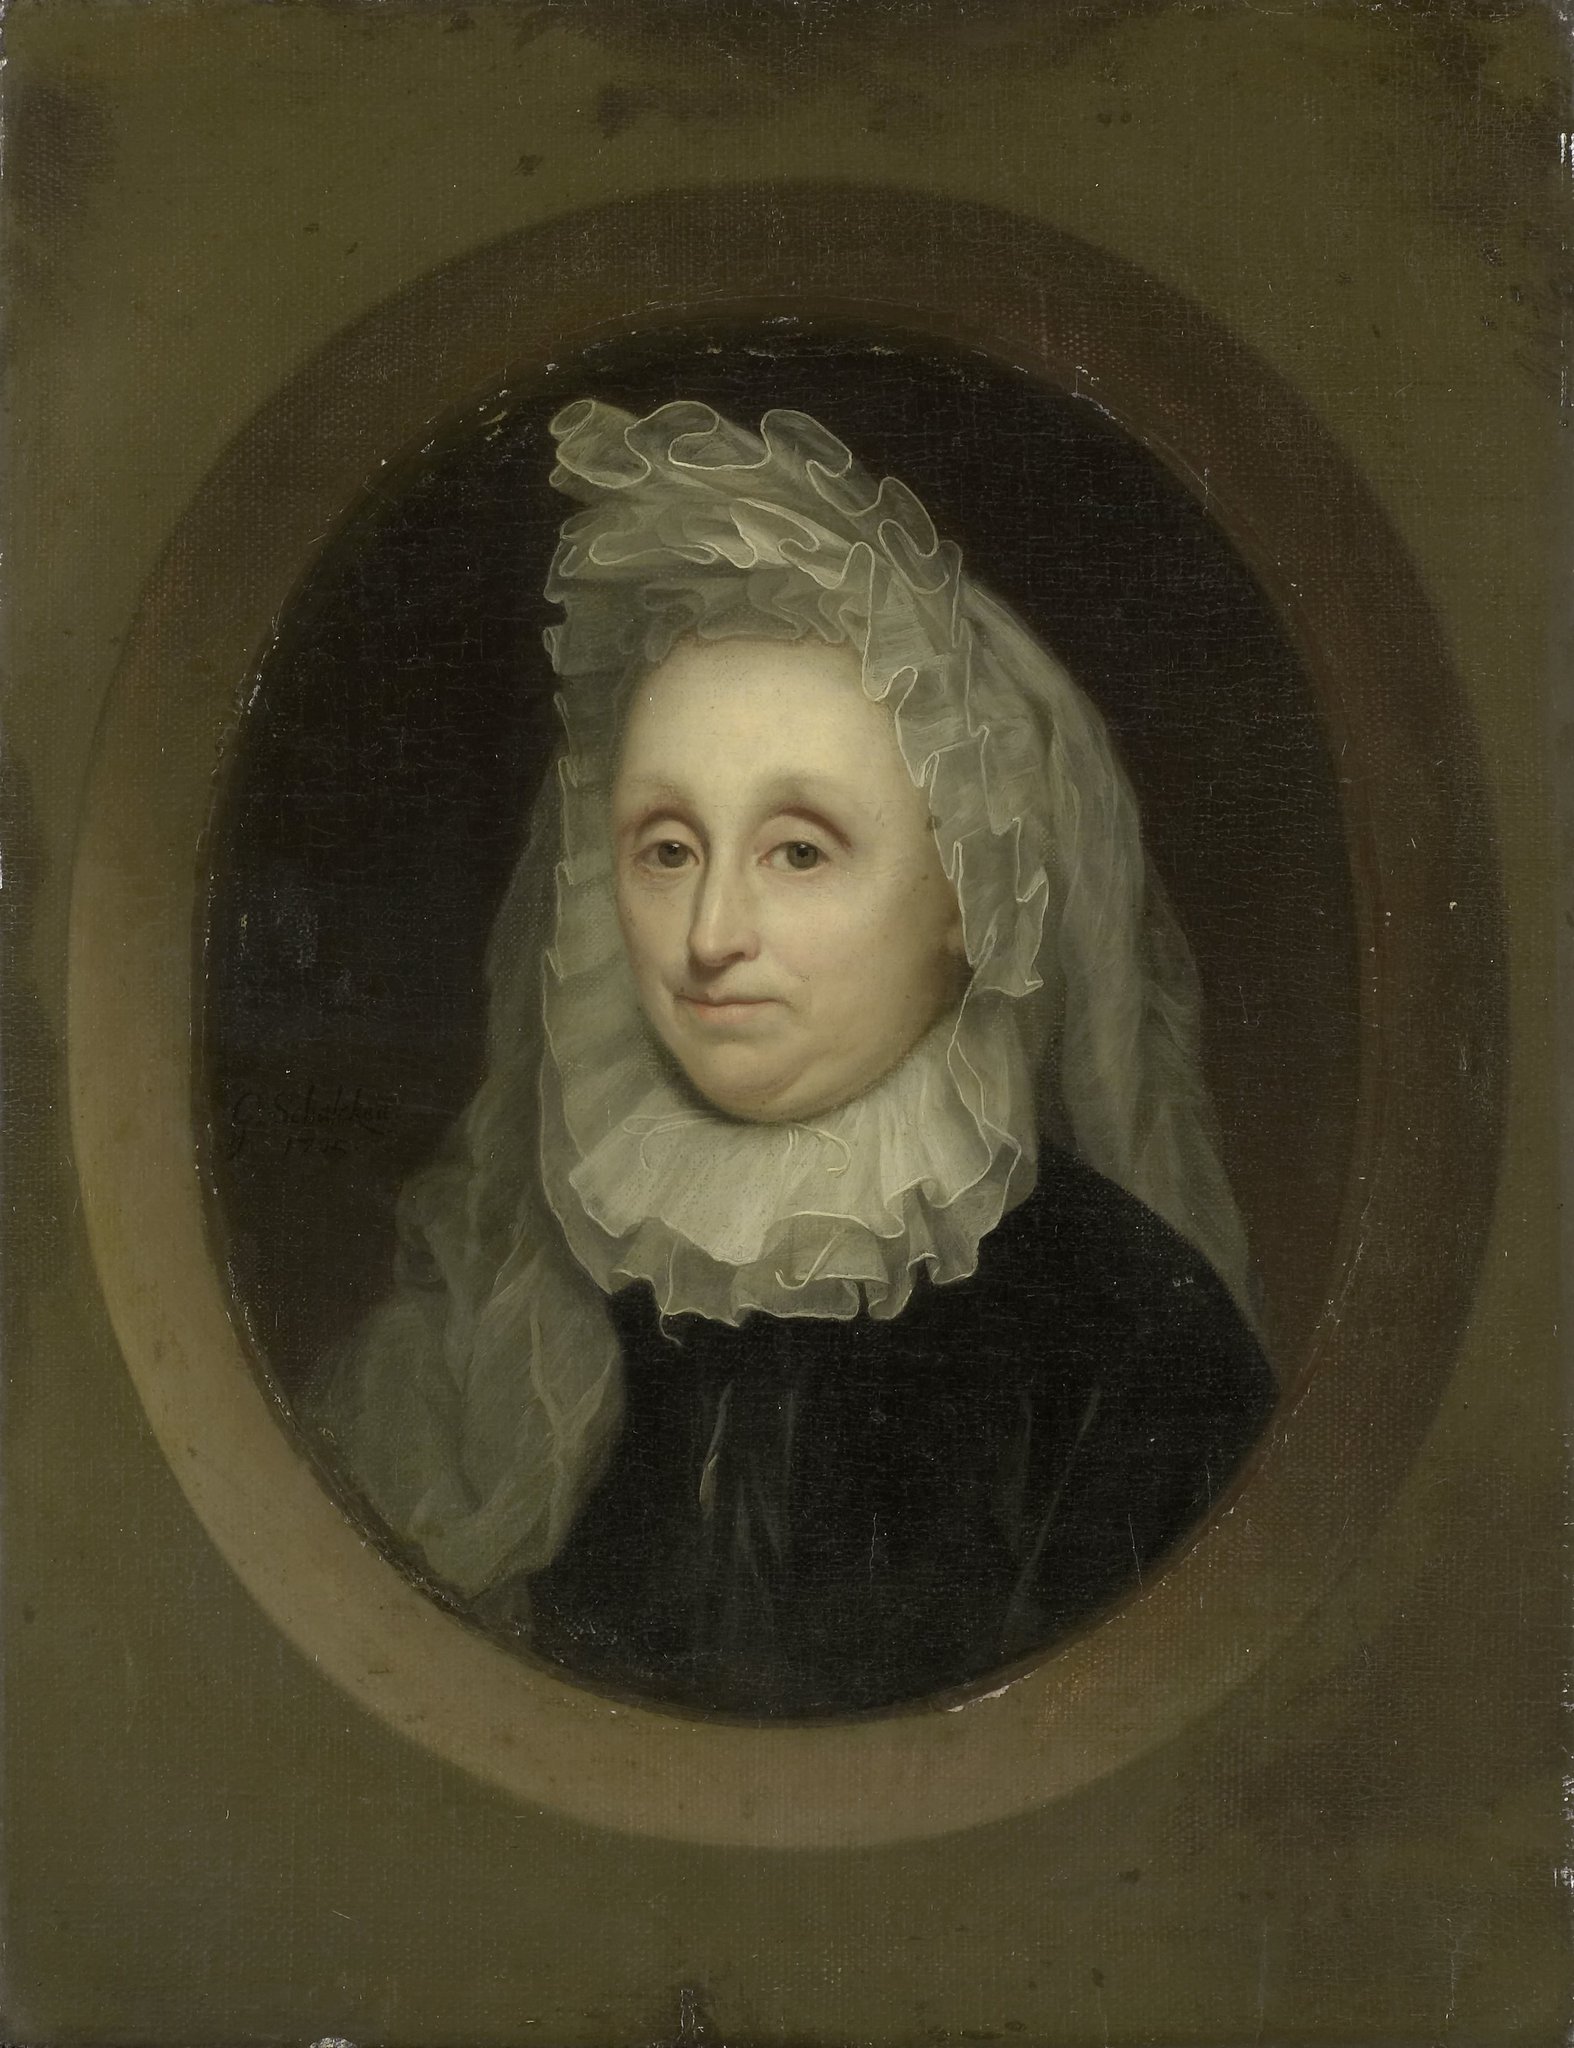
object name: painting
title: Portrait of Josnia Parduyn (1642-1718), second wife of Aernout van Citters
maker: godfried schalcken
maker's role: draughtsman, painter, print maker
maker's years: 1643-1706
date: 1705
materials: canvas, oil, panel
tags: historical persons - bb - woman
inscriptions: inscription: ‘Vrouw Josina parduijn geboren tot dort den 18 Mey 1642 trouwd Binnenen Middelburg den 29 octob.r 1663 den Heer Ambassadeur Aarnout van Citters Heer van Gapinge. sterft 1 Novemb.r 1718 Binnen voornoemde stad. 4’, signature and date: ‘G. Schalcken 1705’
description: Portret van Josina Parduyn (1642-1718), tweede echtgenote van Aernout van Citters. Buste in ovaal, op de achterzijde haar familiewapen en dat van haar vier voorouders (Parduyn, Parduyn, Salomons en Tirion), een inscriptie en de cijfer 4.